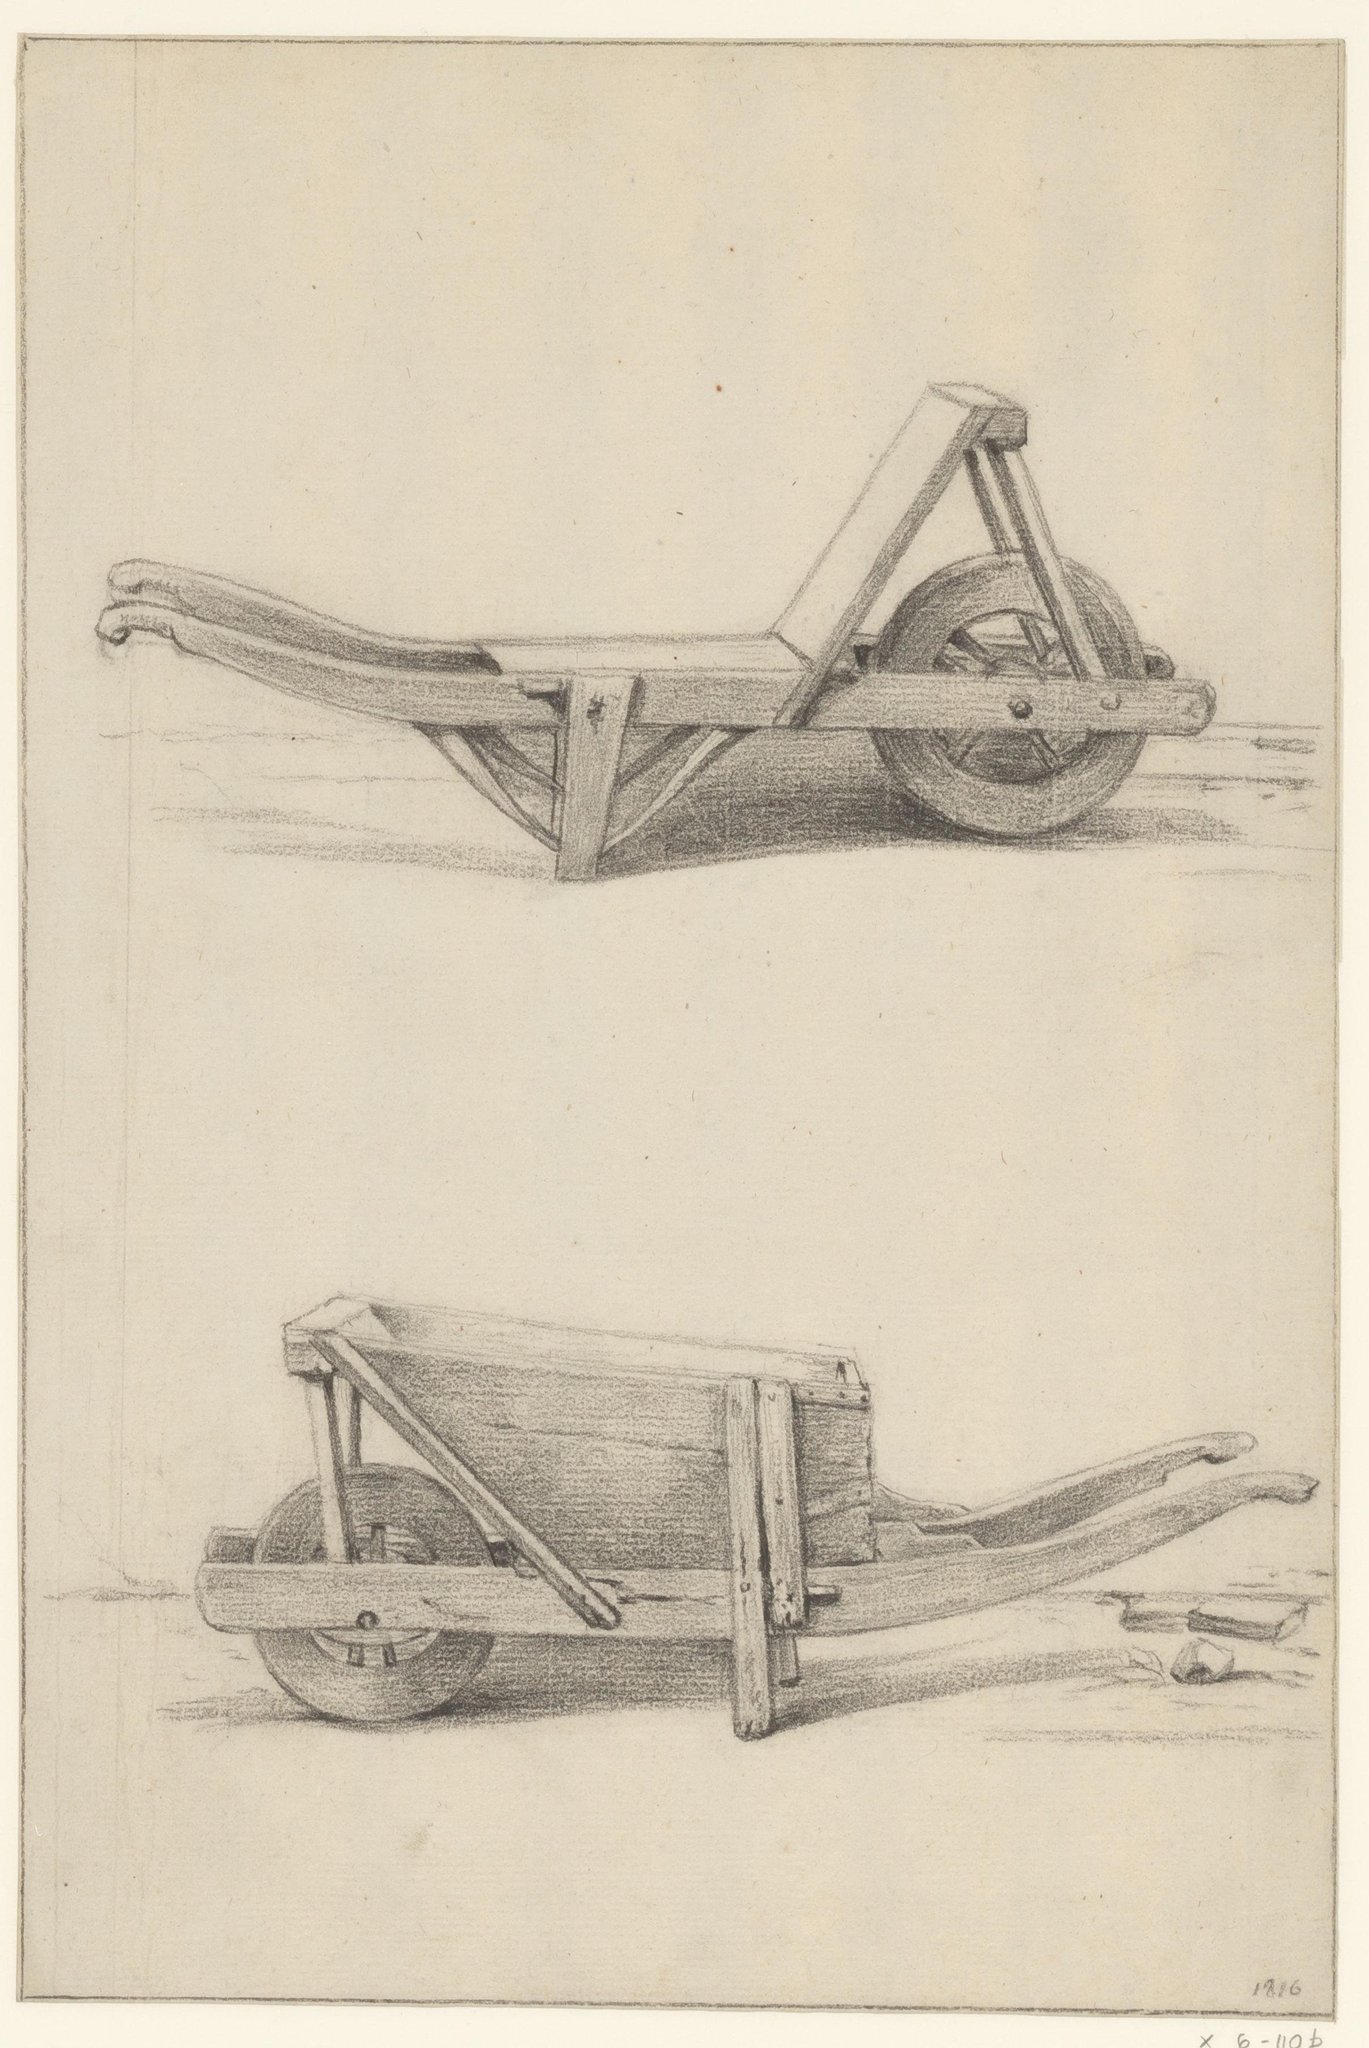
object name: drawing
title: Twee kruiwagens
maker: Anonymous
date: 1816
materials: chalk, paper, pencil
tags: wheelbarrow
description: Onderwerpsrubrieken binnen de Atlas Zeden en Gewoonten: Handel, nijverheid en verkeer, Vervoermiddelen te land en te water, vervoermiddelen te land, Vrachtwagens.